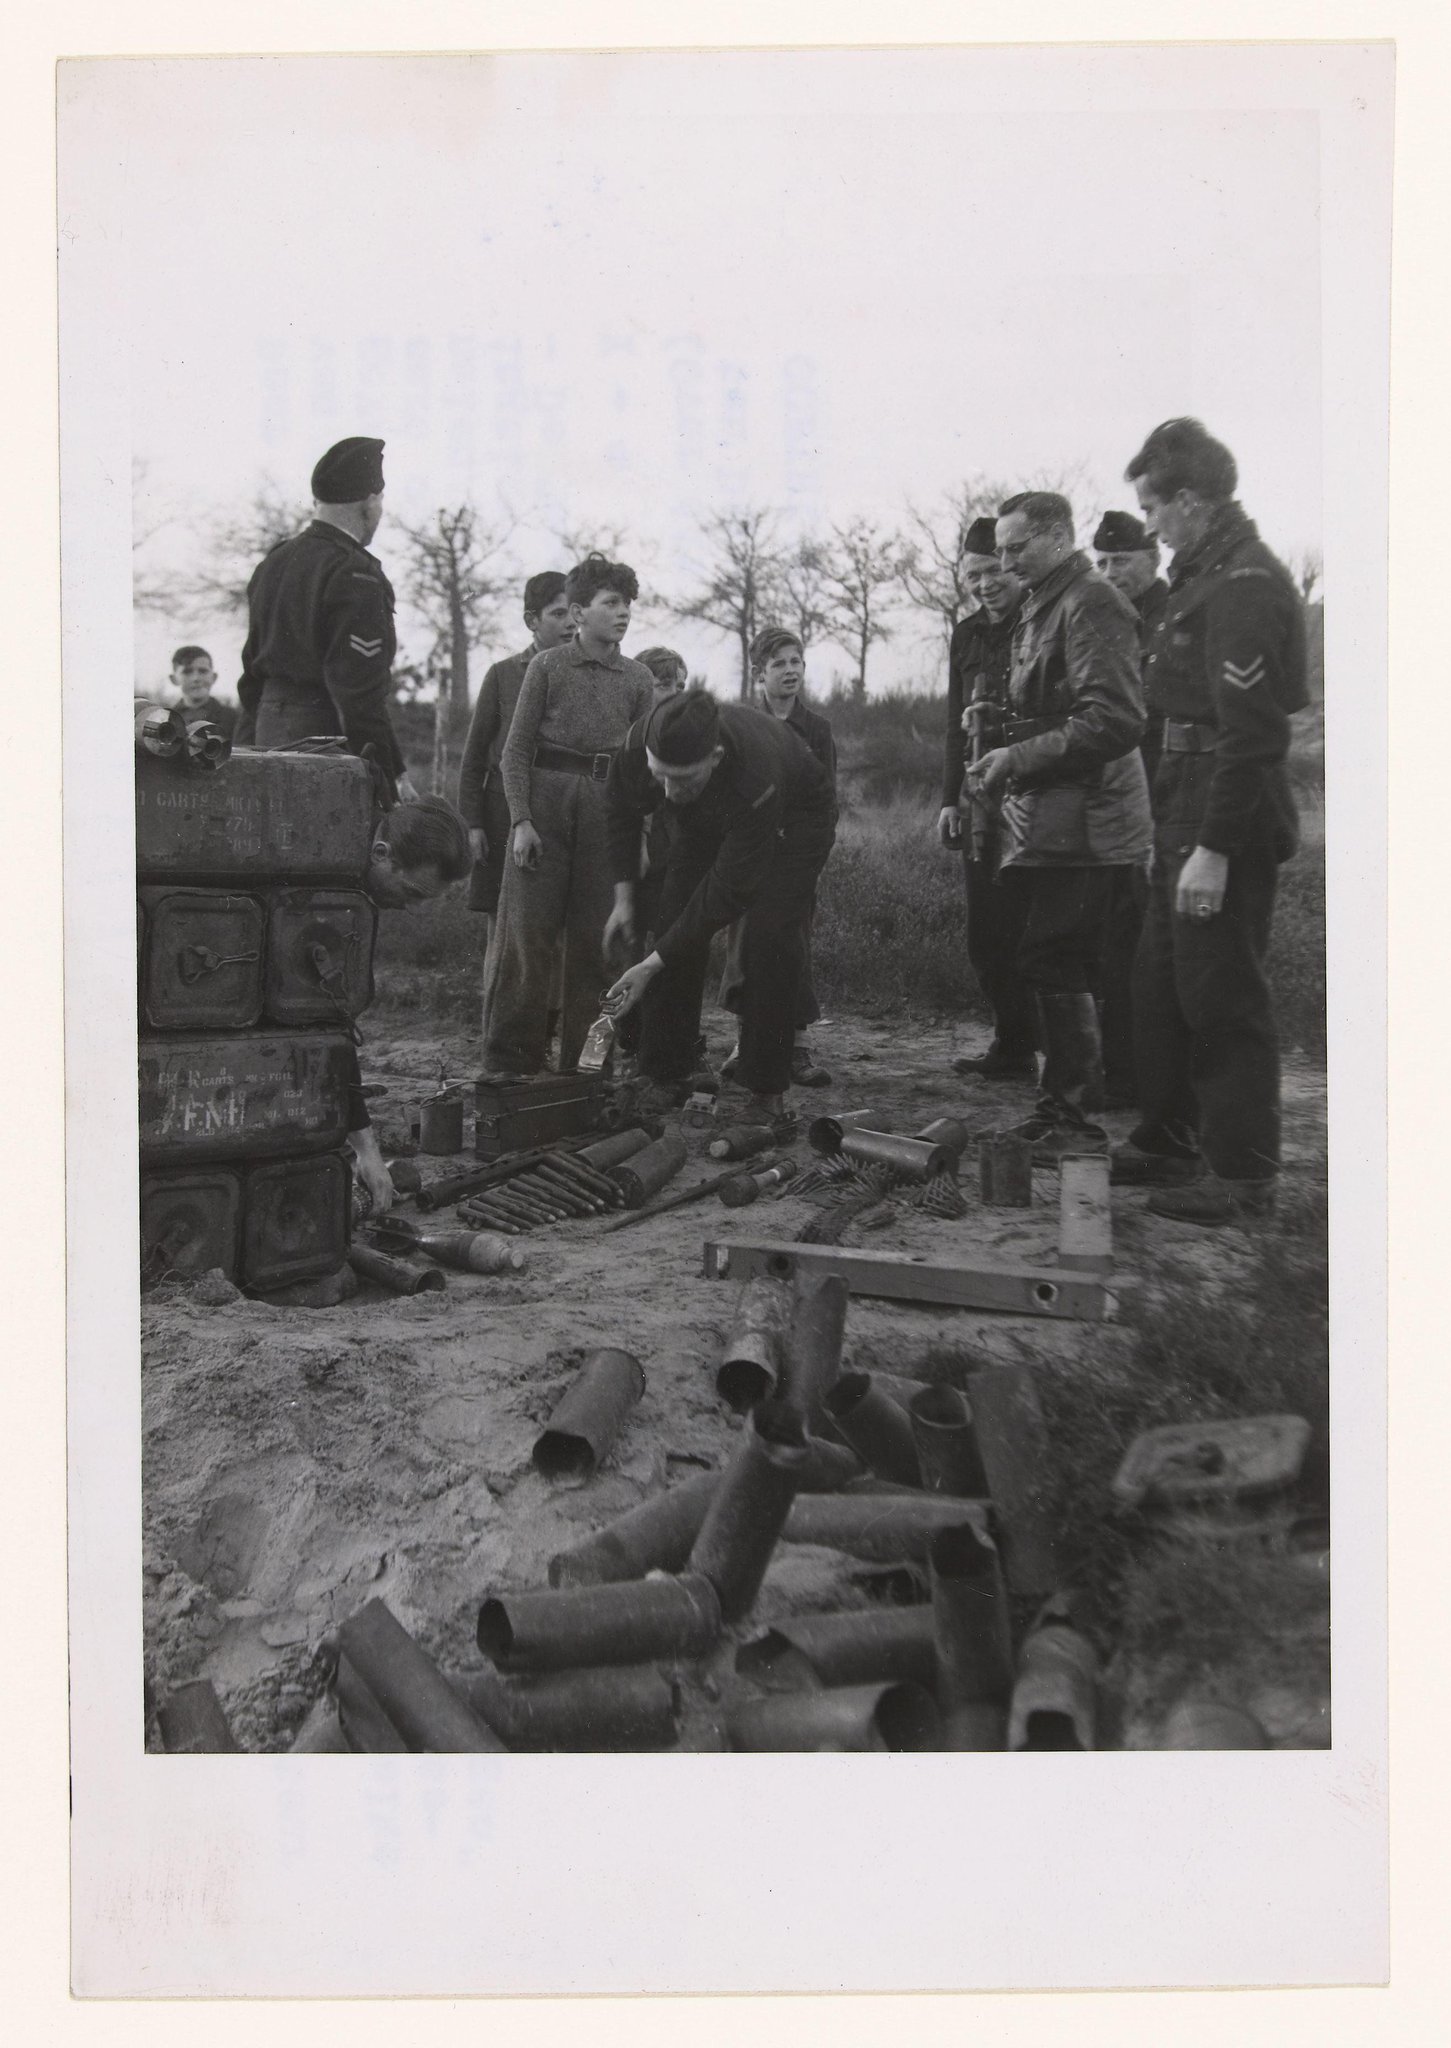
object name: documentary photograph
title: Rijkspolitie spreekt kinderen toe bij het oprapen van wapens van de slagvelden in Zuid-Nederland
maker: charles breijer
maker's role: fotograaf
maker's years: 1914-2011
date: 1945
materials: photographic support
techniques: photography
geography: southern netherlands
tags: the hague, charles breijer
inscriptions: number: ‘12832’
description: In een zandlandschap staat een groep kinderen en rijkspolitiemannen temidden van overblijfselen van wapentuig. De rijkspolitie wijst de jongens op het feit dat zij de gevonden wapens behoren in te leveren en waarschuwt tegen de mogelijke gevaren.